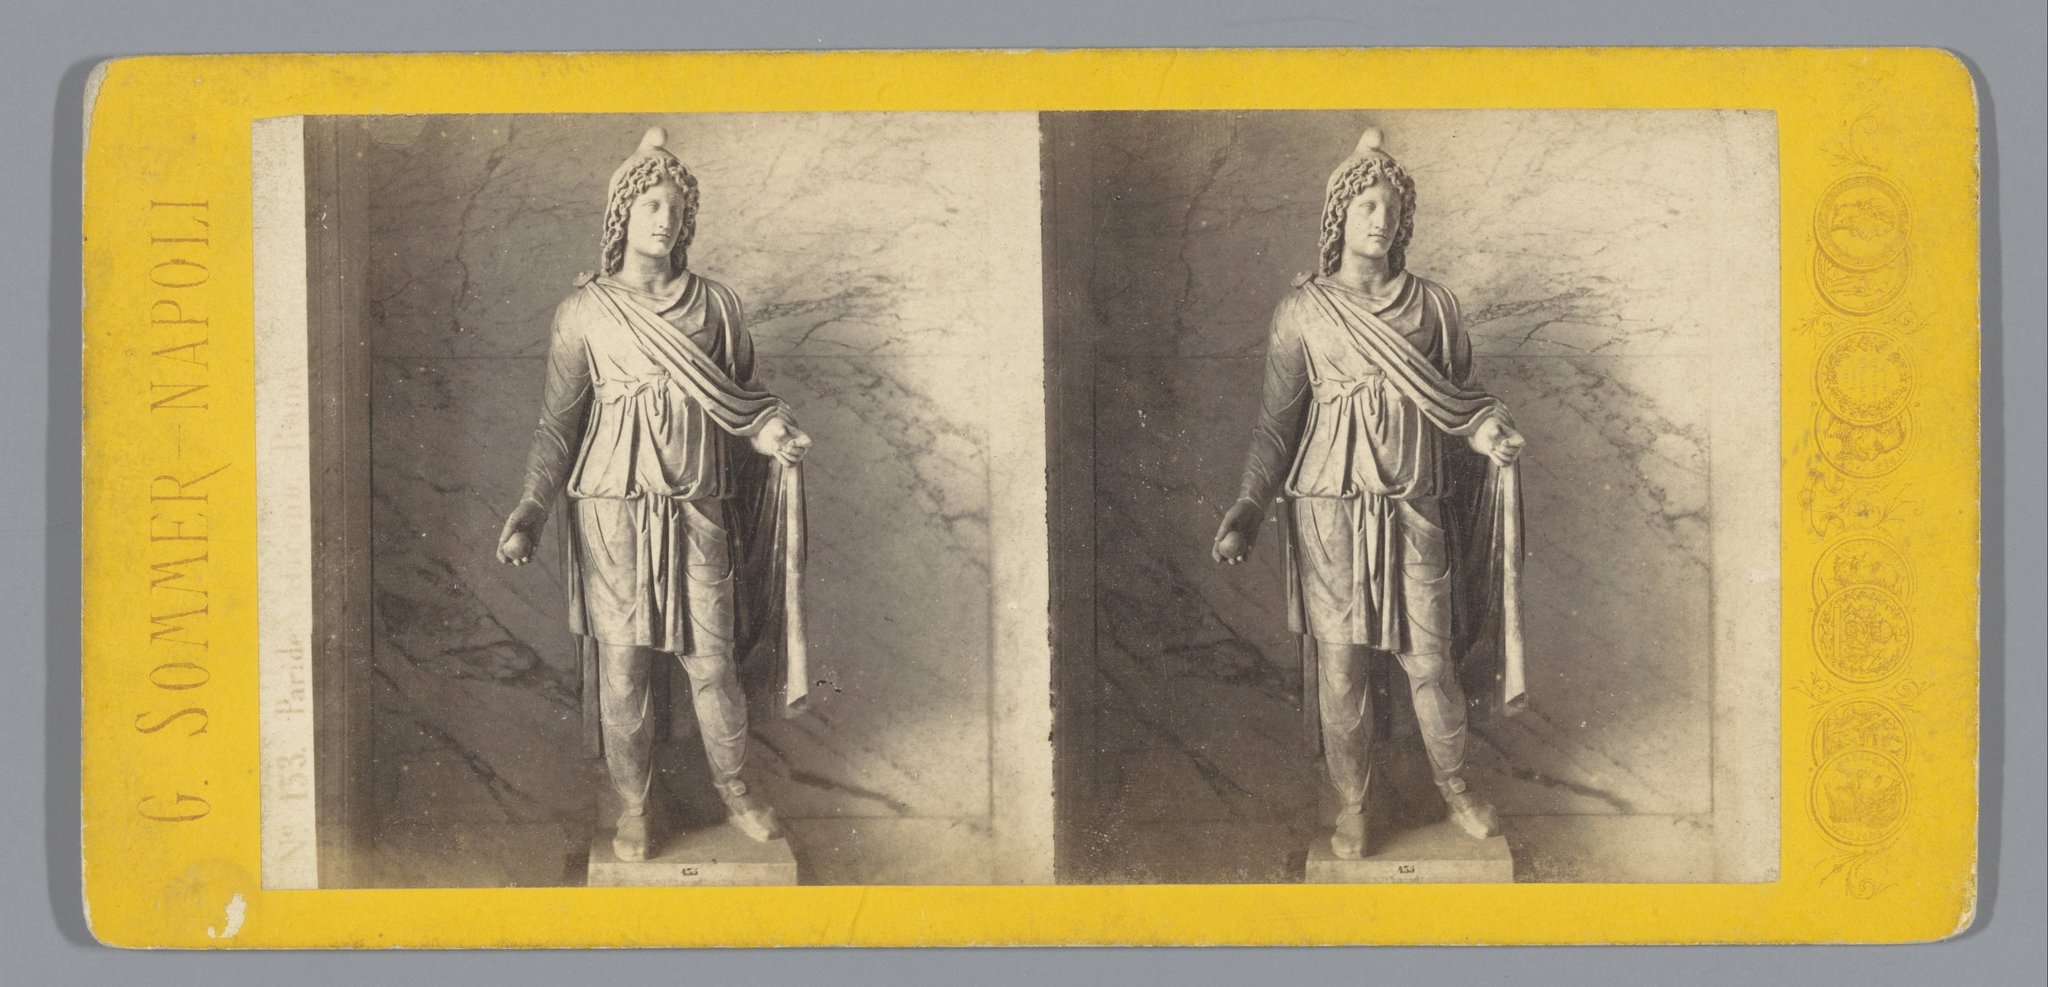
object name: stereograph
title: Paride, Vaticano, Roma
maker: giorgio sommer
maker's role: fotograaf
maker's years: 1834-1914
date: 1860-1880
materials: cardboard, photographic support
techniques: albumen print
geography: vatican museums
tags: piece of sculpture, reproduction of a piece of sculpture, (story of) paris (alexander)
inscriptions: number: ‘No. 153.’, inscription: ‘Rome : Vaticaan : Paris’